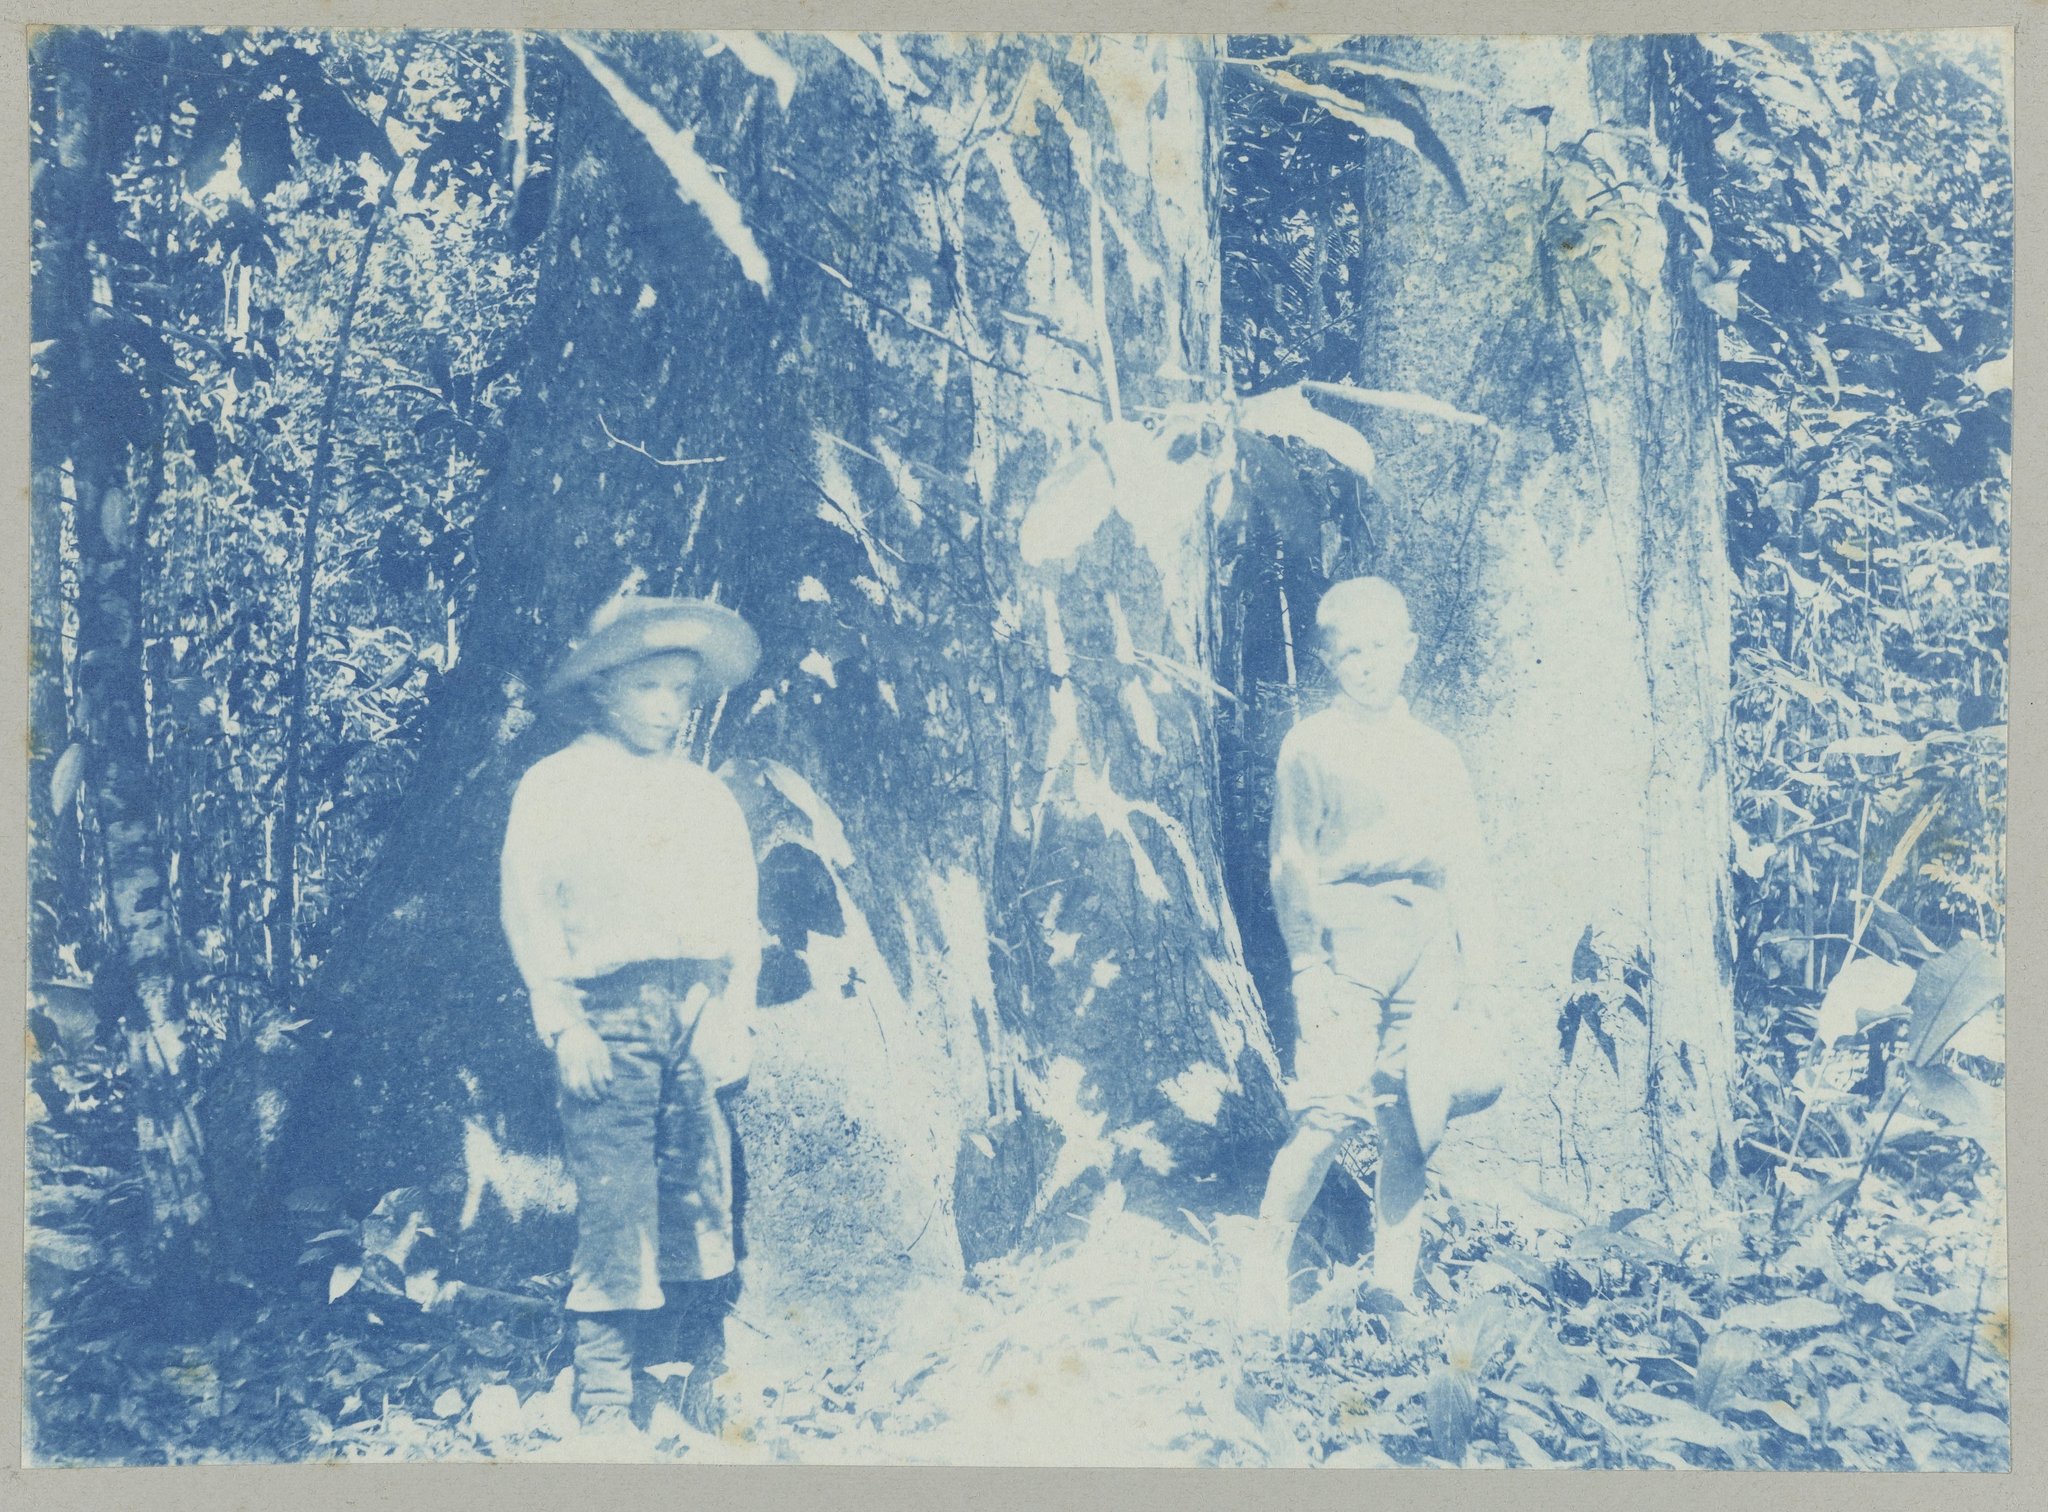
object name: photograph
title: Anton en Piet achter Tourtonne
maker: hendrik doijer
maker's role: engineer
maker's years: 1863-1925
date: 1903-1910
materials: photographic support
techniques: cyanotype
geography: suriname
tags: suriname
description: Twee jongens genaamd Anton en Piet staande voor bomen achter de plantage Tourtonne. Onderdeel van het fotoalbum Souvenir de Voyage (deel 1), over het leven van de familie Doijer in en rond de plantage Ma Retraite in Suriname in de jaren 1903-1910.